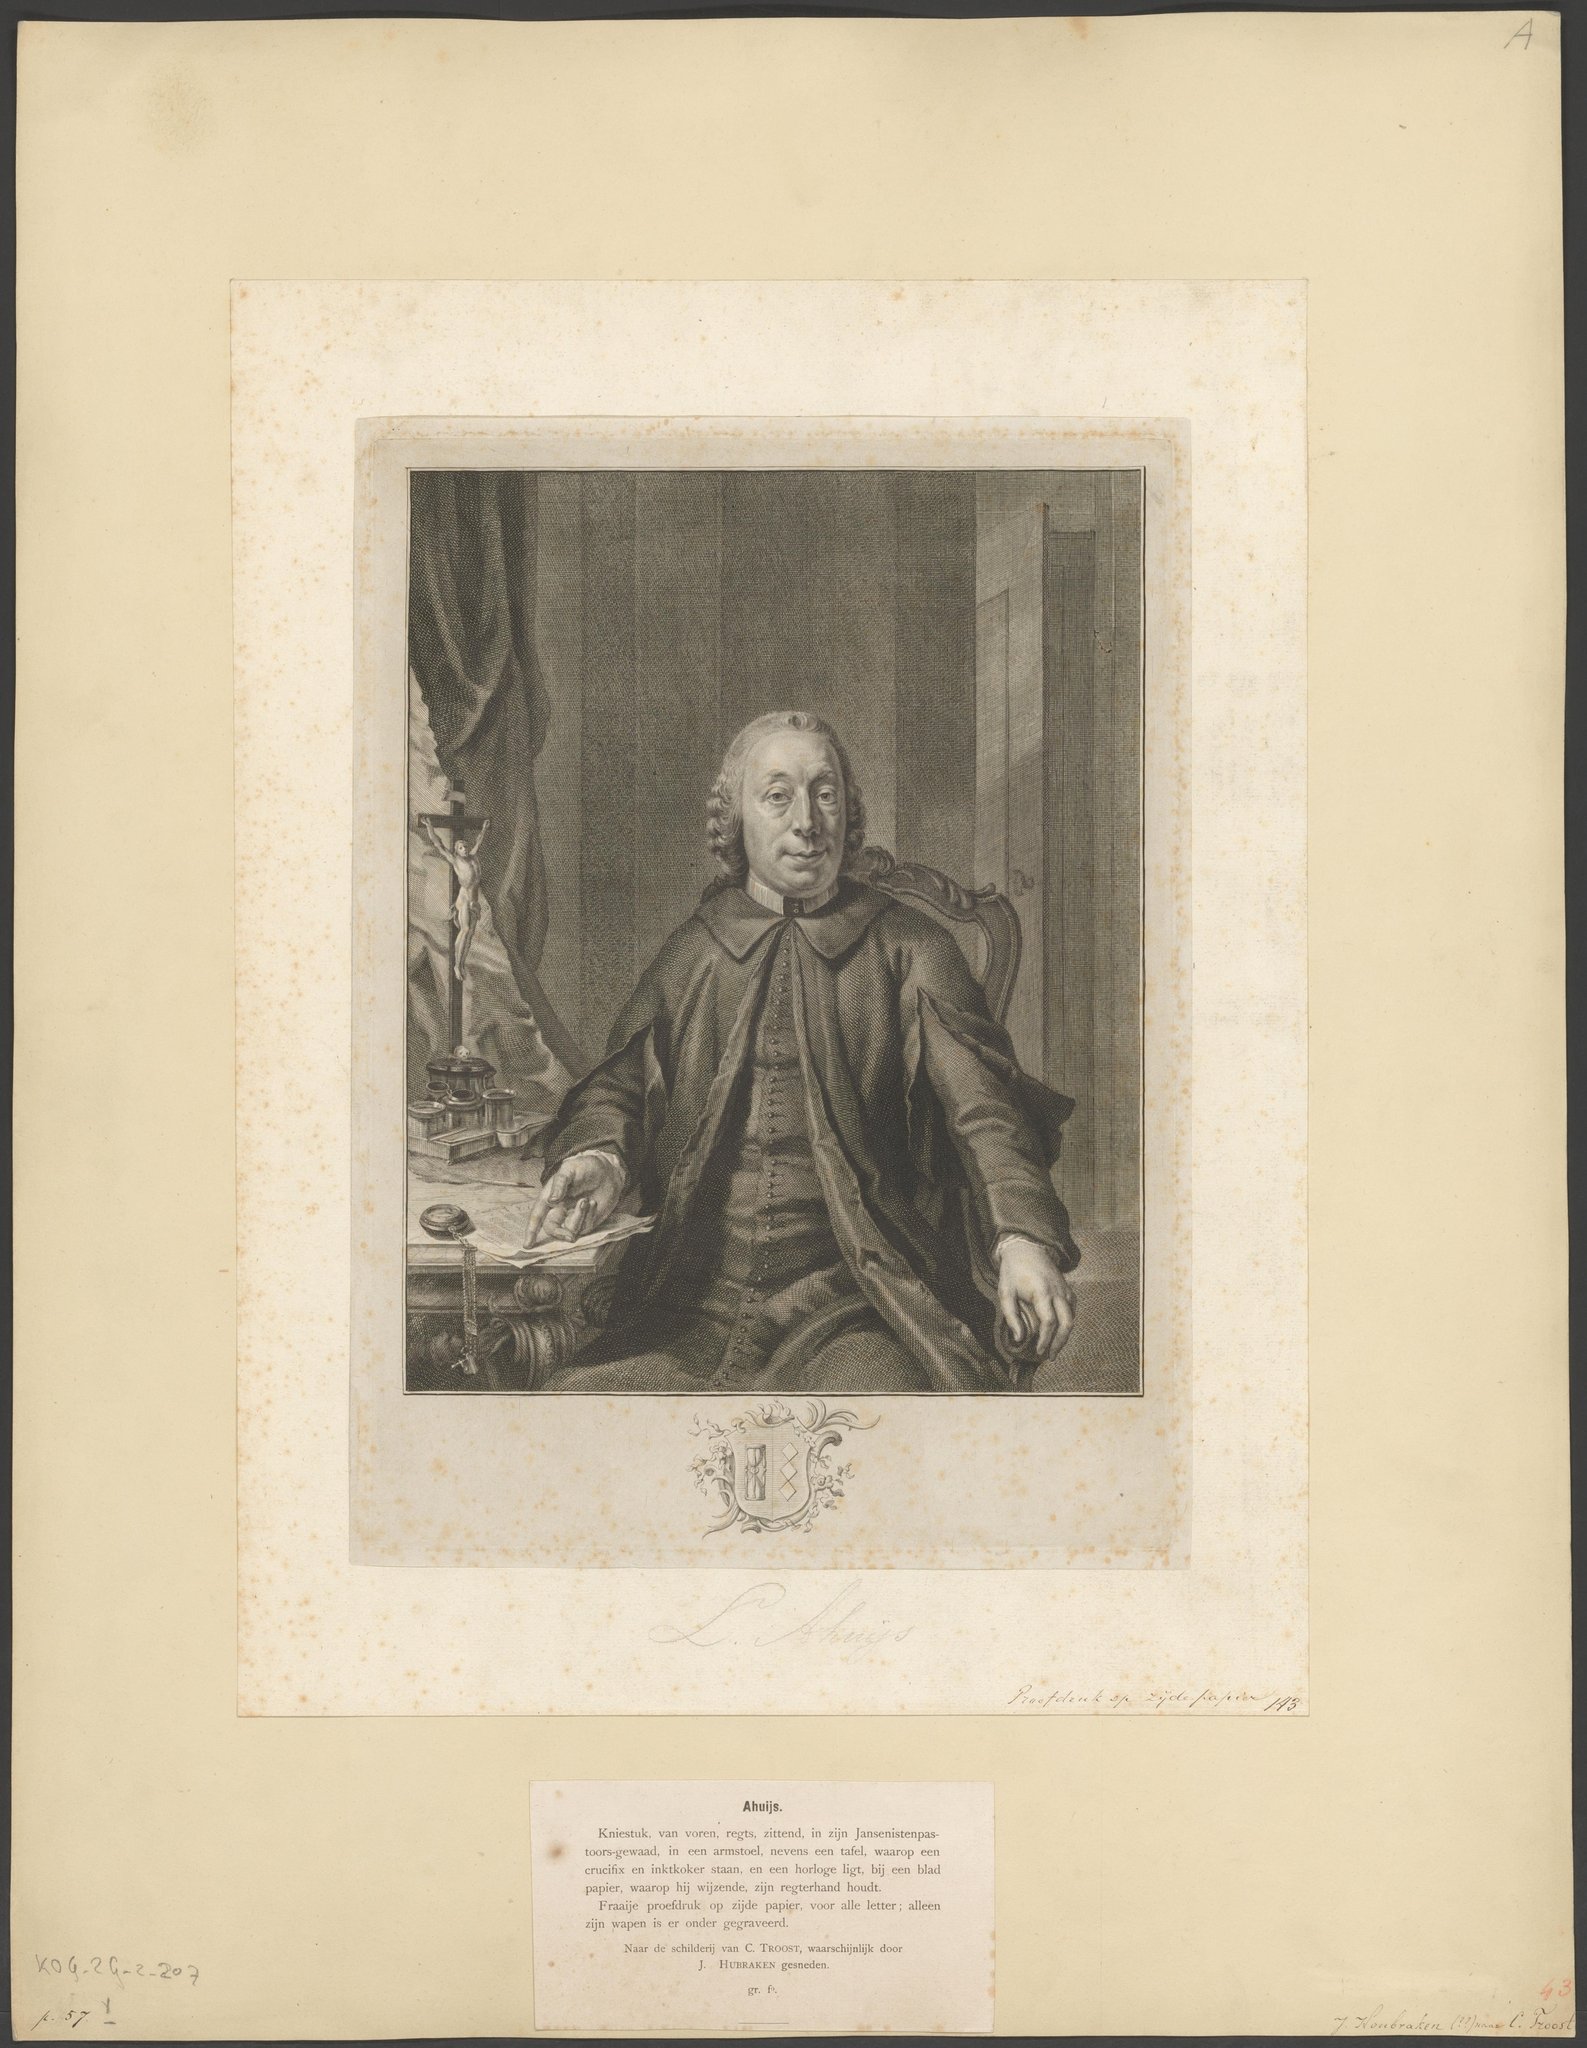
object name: print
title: Portret van Lucas Ahuys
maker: jacob houbraken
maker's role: draughtsman, print maker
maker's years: 1698-1780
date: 1730-1734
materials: paper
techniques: engraving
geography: amsterdam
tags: historical persons, crucifix ~ personal devotion, watch, theologian in his study (writing or reading)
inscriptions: collector's mark: Lugt 2488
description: Kniestuk van pastoor Lucas Ahuys, zittend in een geestelijk gewaad aan een tafel waarop een crucifix en schrijfgerei. Onder het portret een wapen.